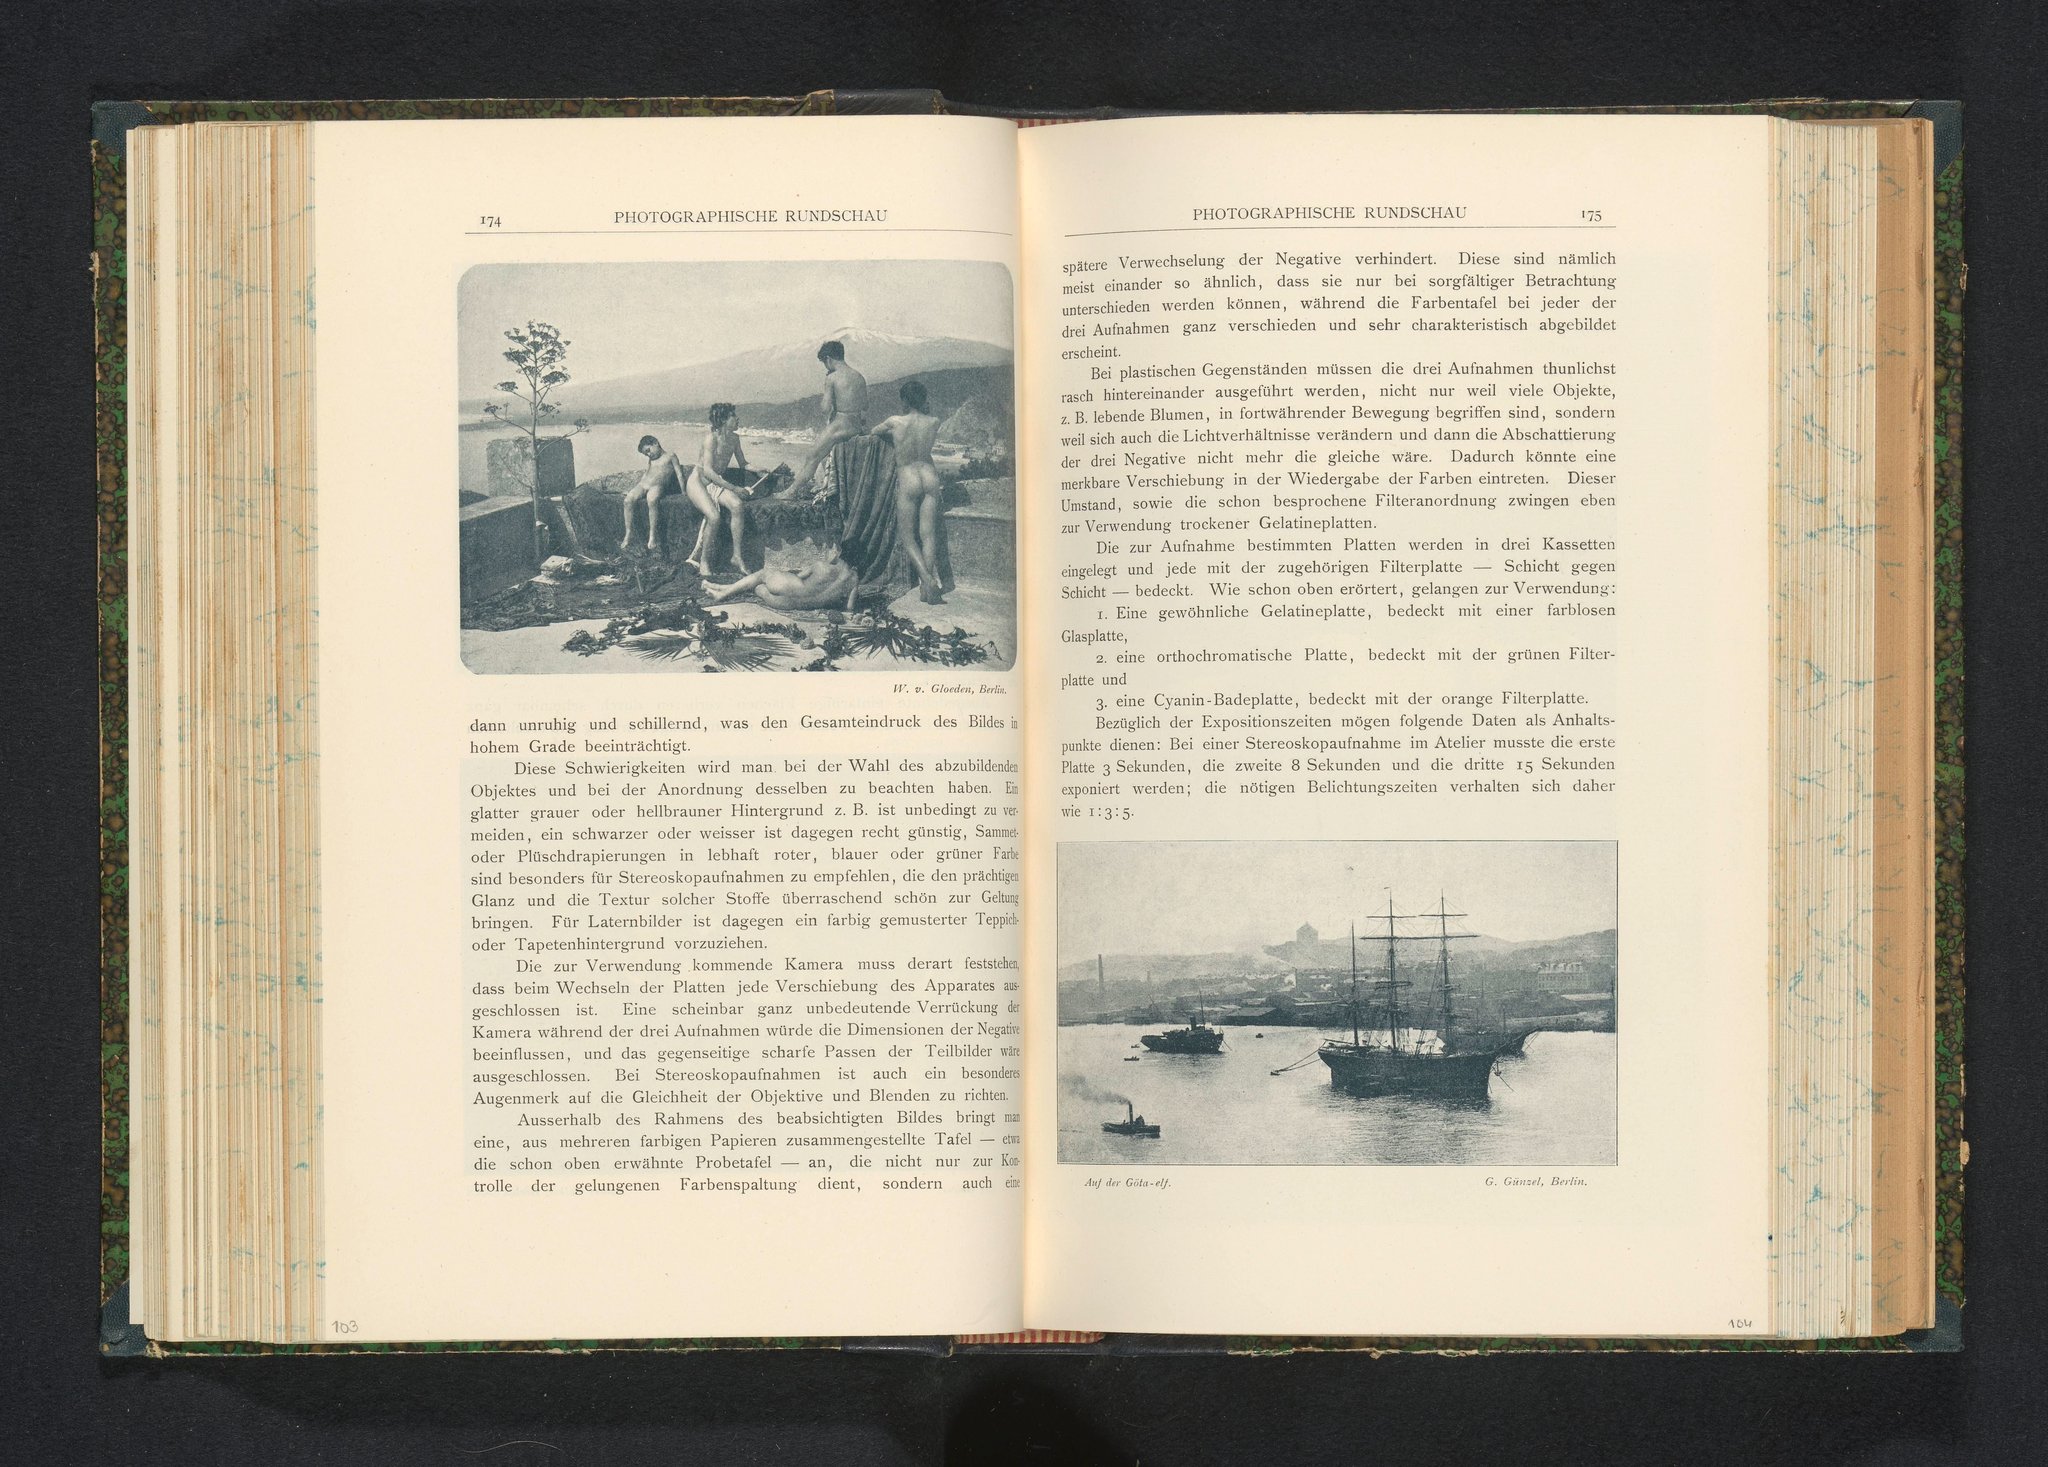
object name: photomechanical print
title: Groep naakte jongens op een terras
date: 1894-1899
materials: paper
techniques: autotype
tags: youth, adolescent, terrace